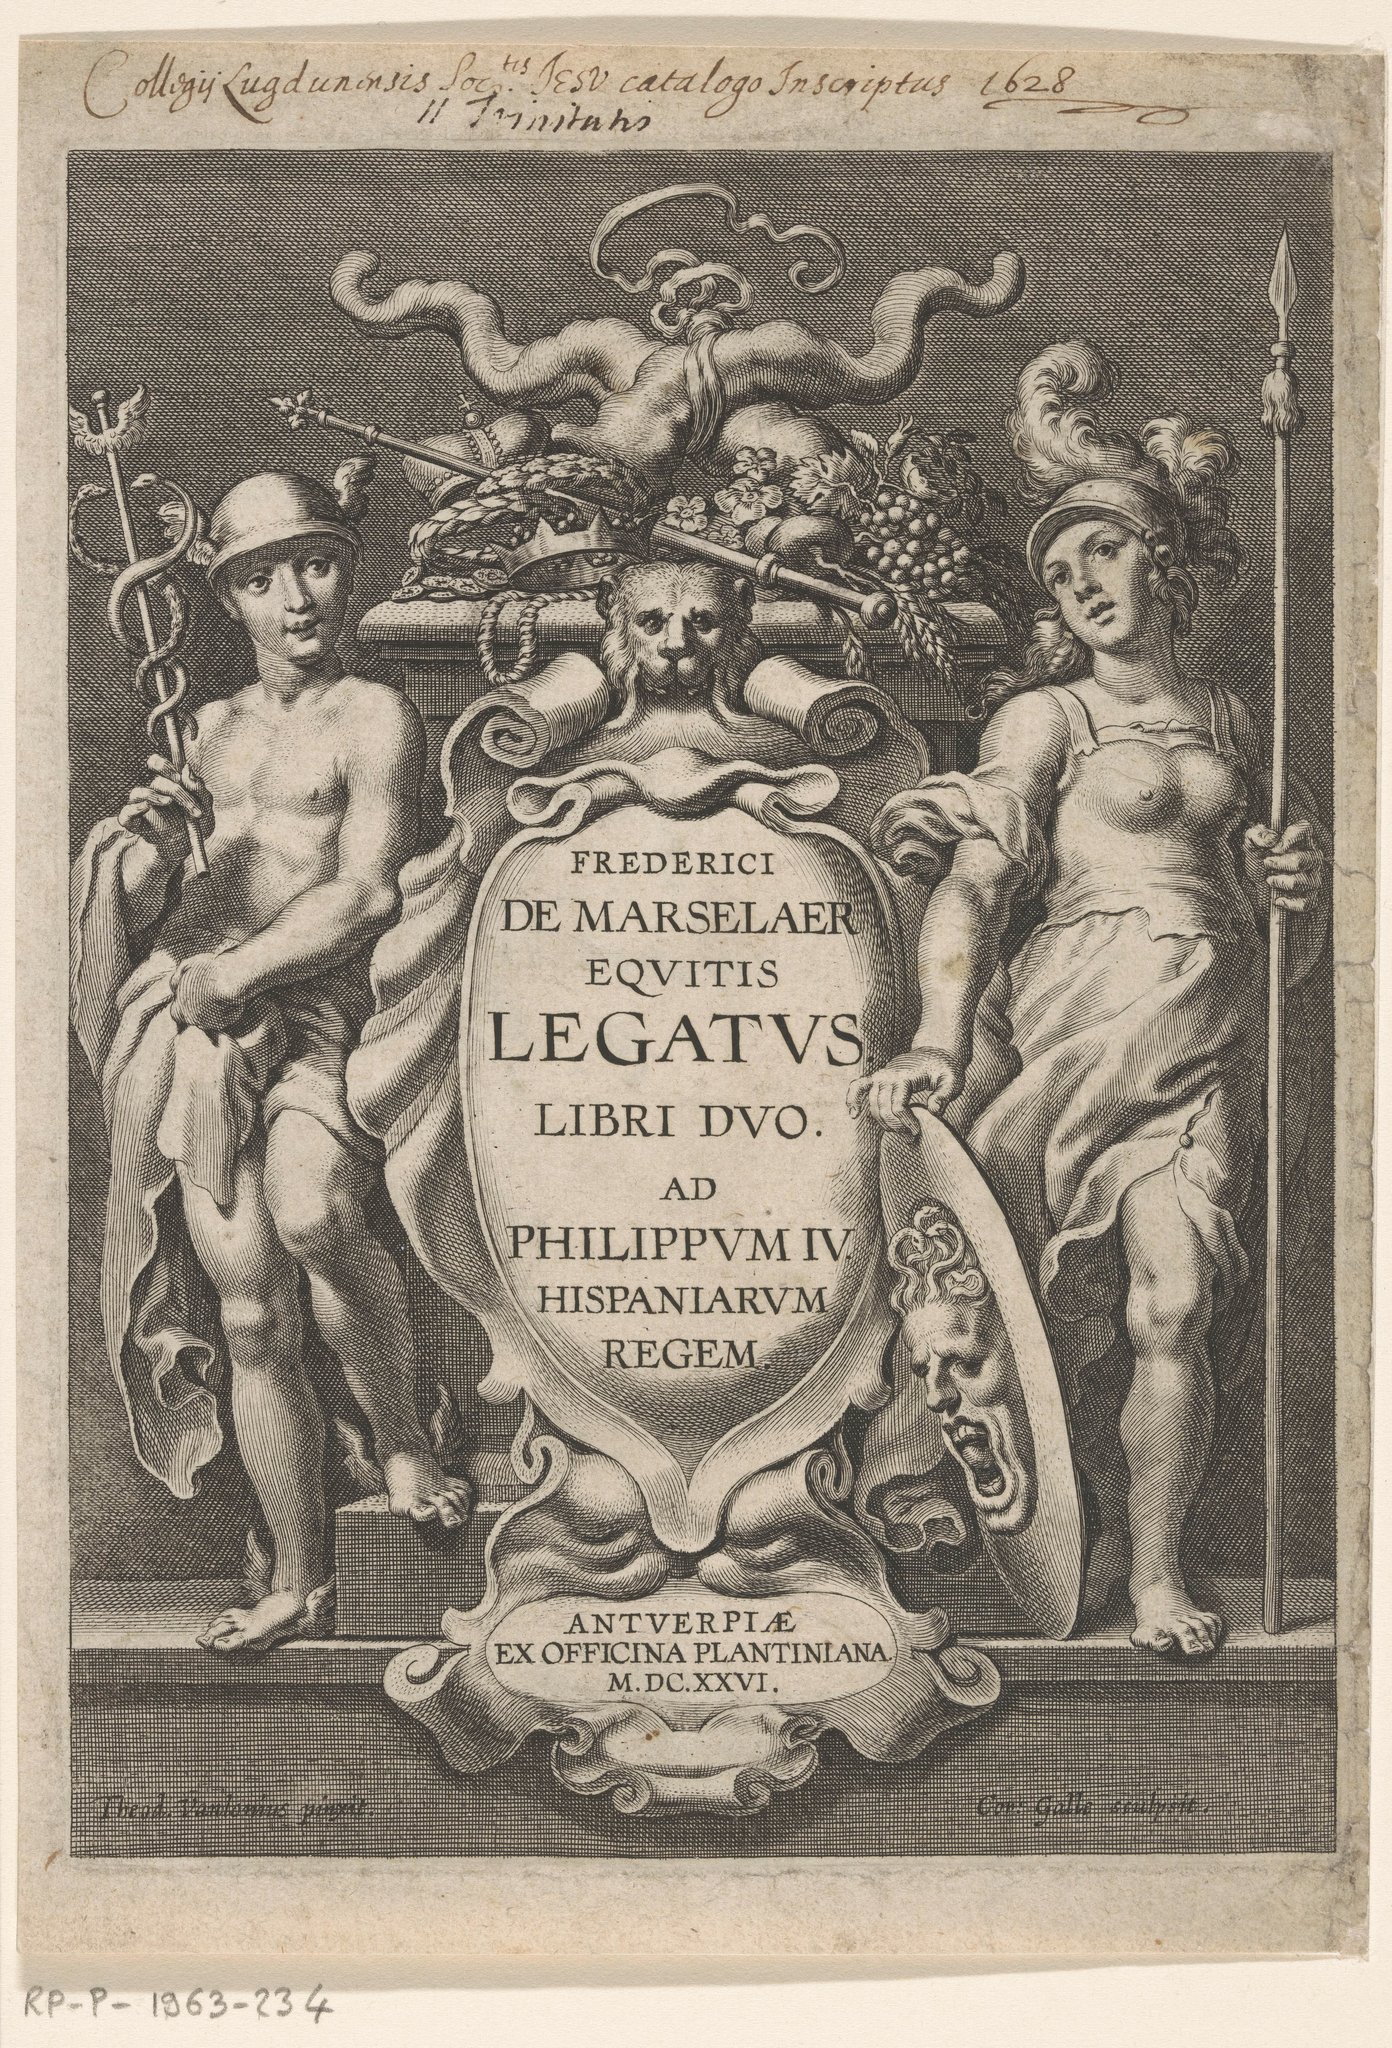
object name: print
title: Titelpagina van: Frederik de Marselaer, Equitis Legatus, Antwerpen, 1626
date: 1626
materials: paper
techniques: engraving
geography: southern netherlands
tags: (story of) minerva (pallas, athena), (story of) mercury (hermes)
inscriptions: collector's mark: Lugt 2228, inscription: ‘Collegii Lugdunensis Soc.tis. Iesv [ Il Trinitatis] catalogo Inscriptus 1628’, collector's mark: Lugt 2760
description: Titelpagina van: Frederik de Marselaer, Equitis Legatus, 2e deel. Antwerpen: ex officina Plantiniana, 1626.